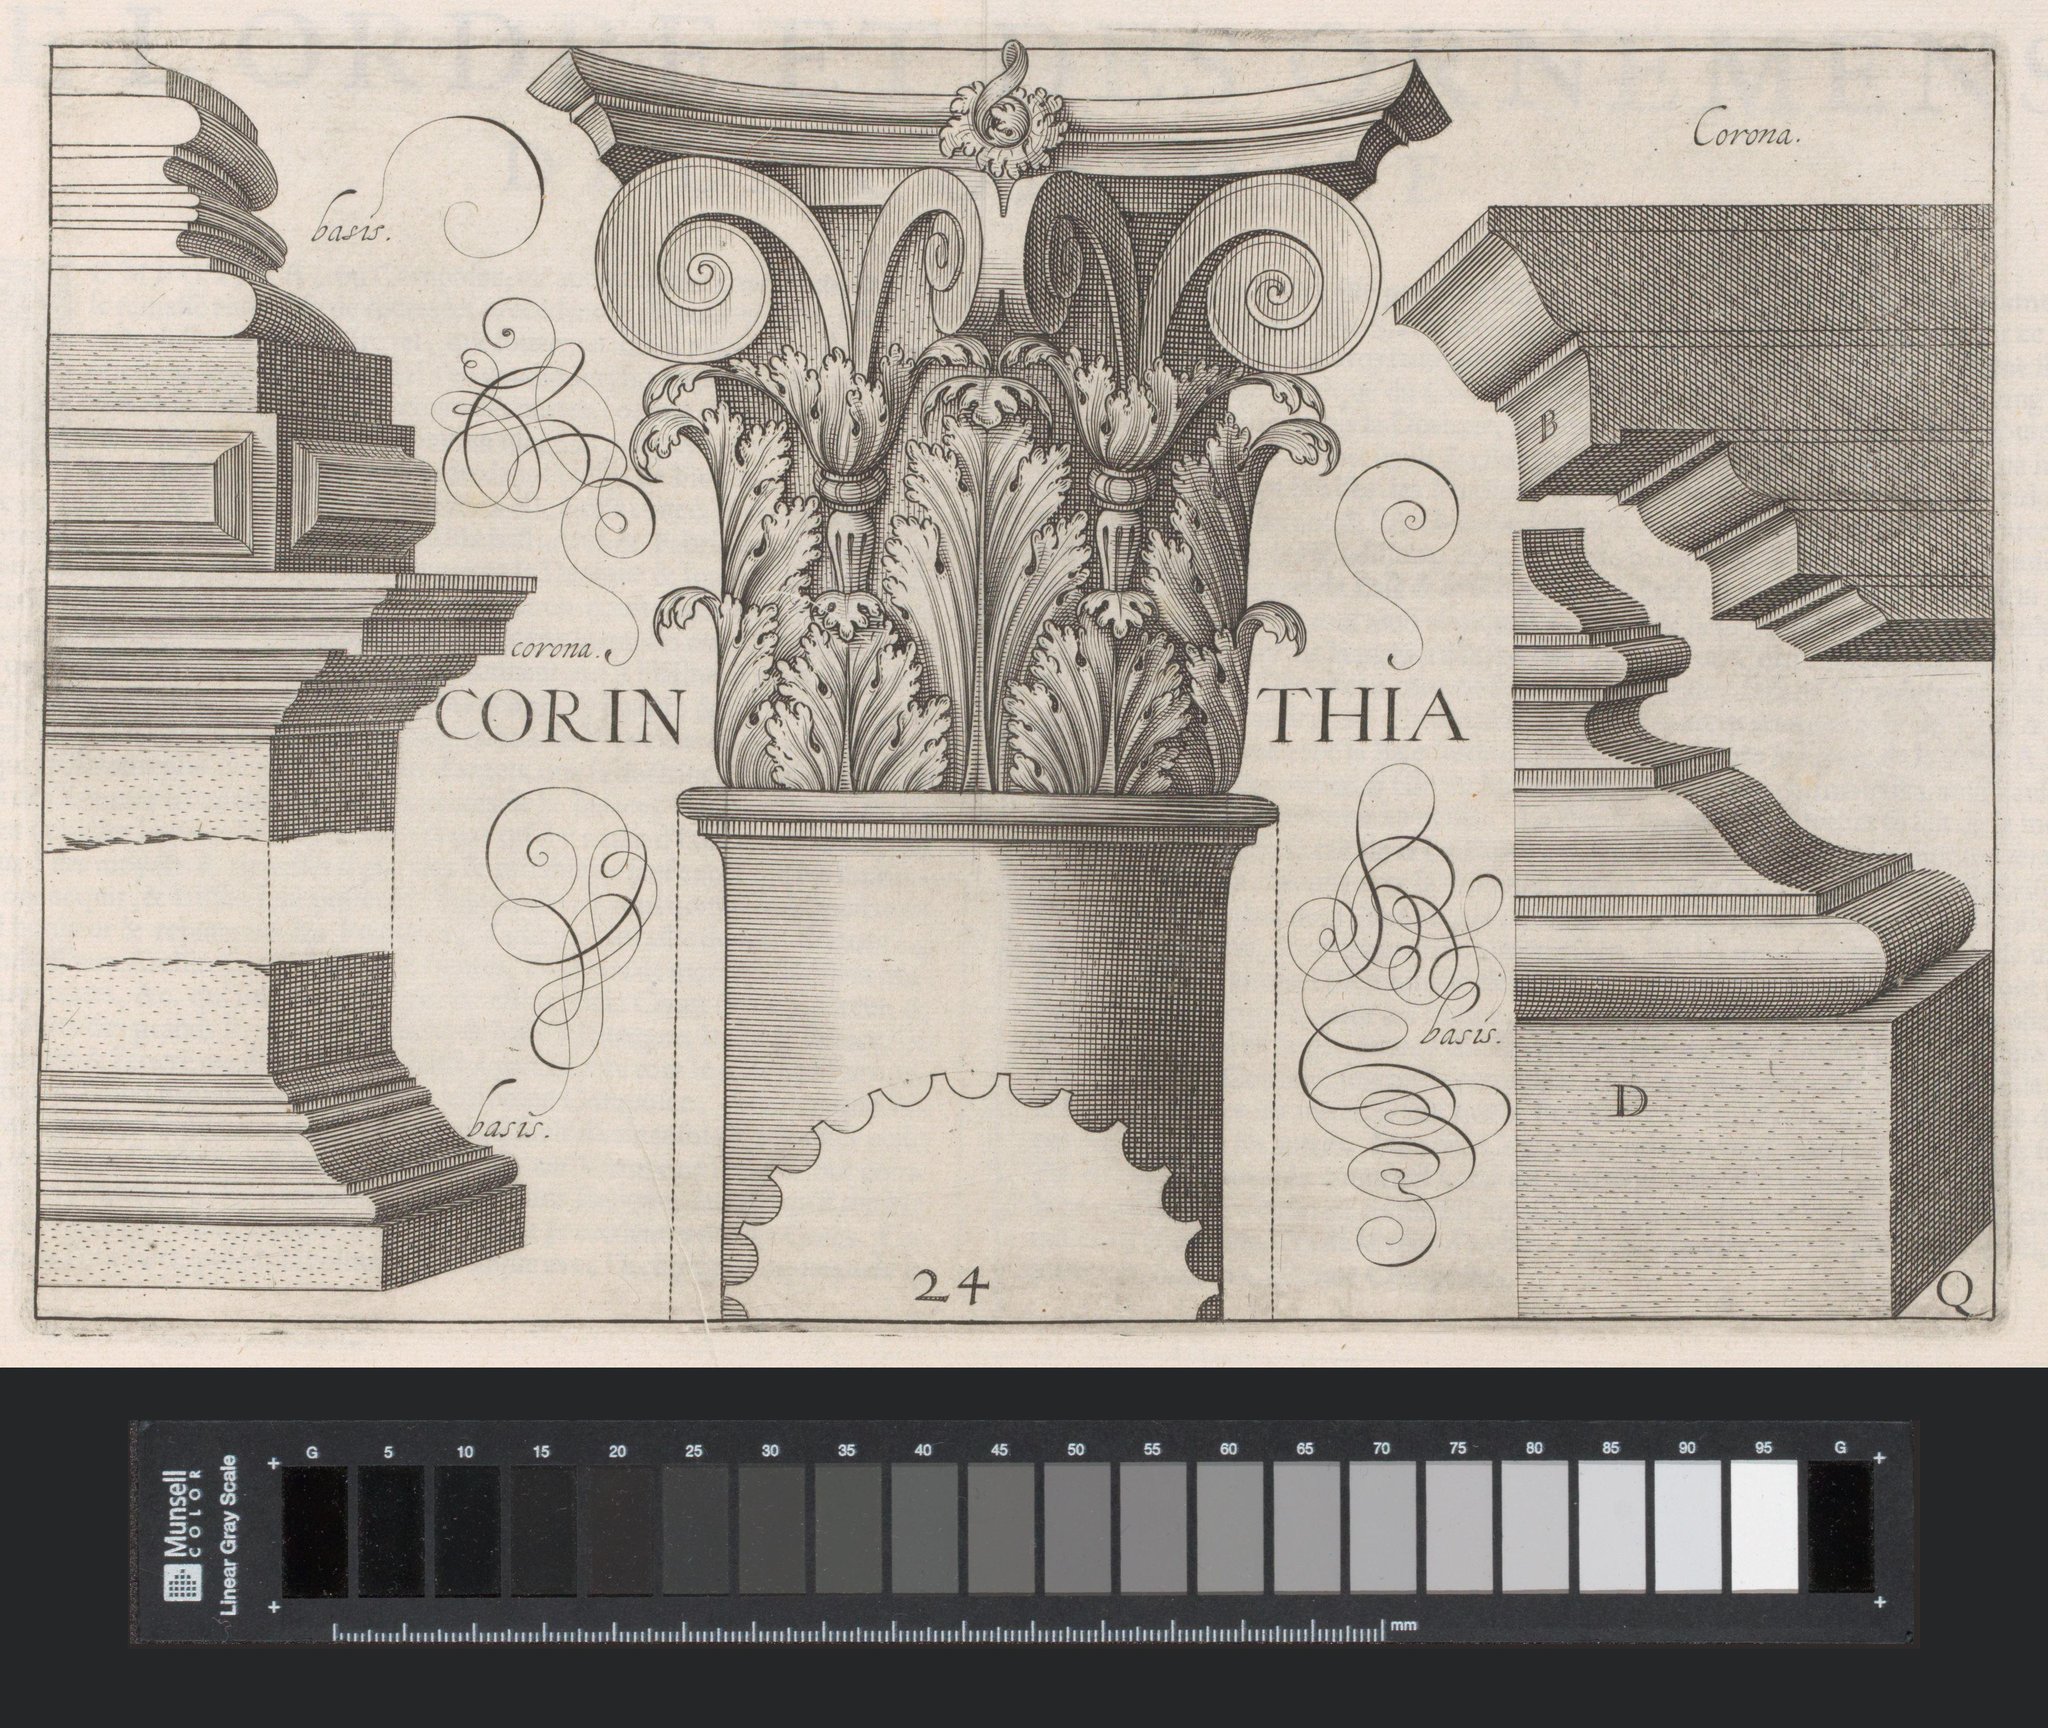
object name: print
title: Korinthisch kapiteel en basement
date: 1606-1607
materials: paper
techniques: engraving, etching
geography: the hague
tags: corinthian order ~ architecture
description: Details van de Korinthische bouworde: basement, kapiteel en hoofdgestel. Rechtsonder: Q. Prent maakt deel uit van een album.